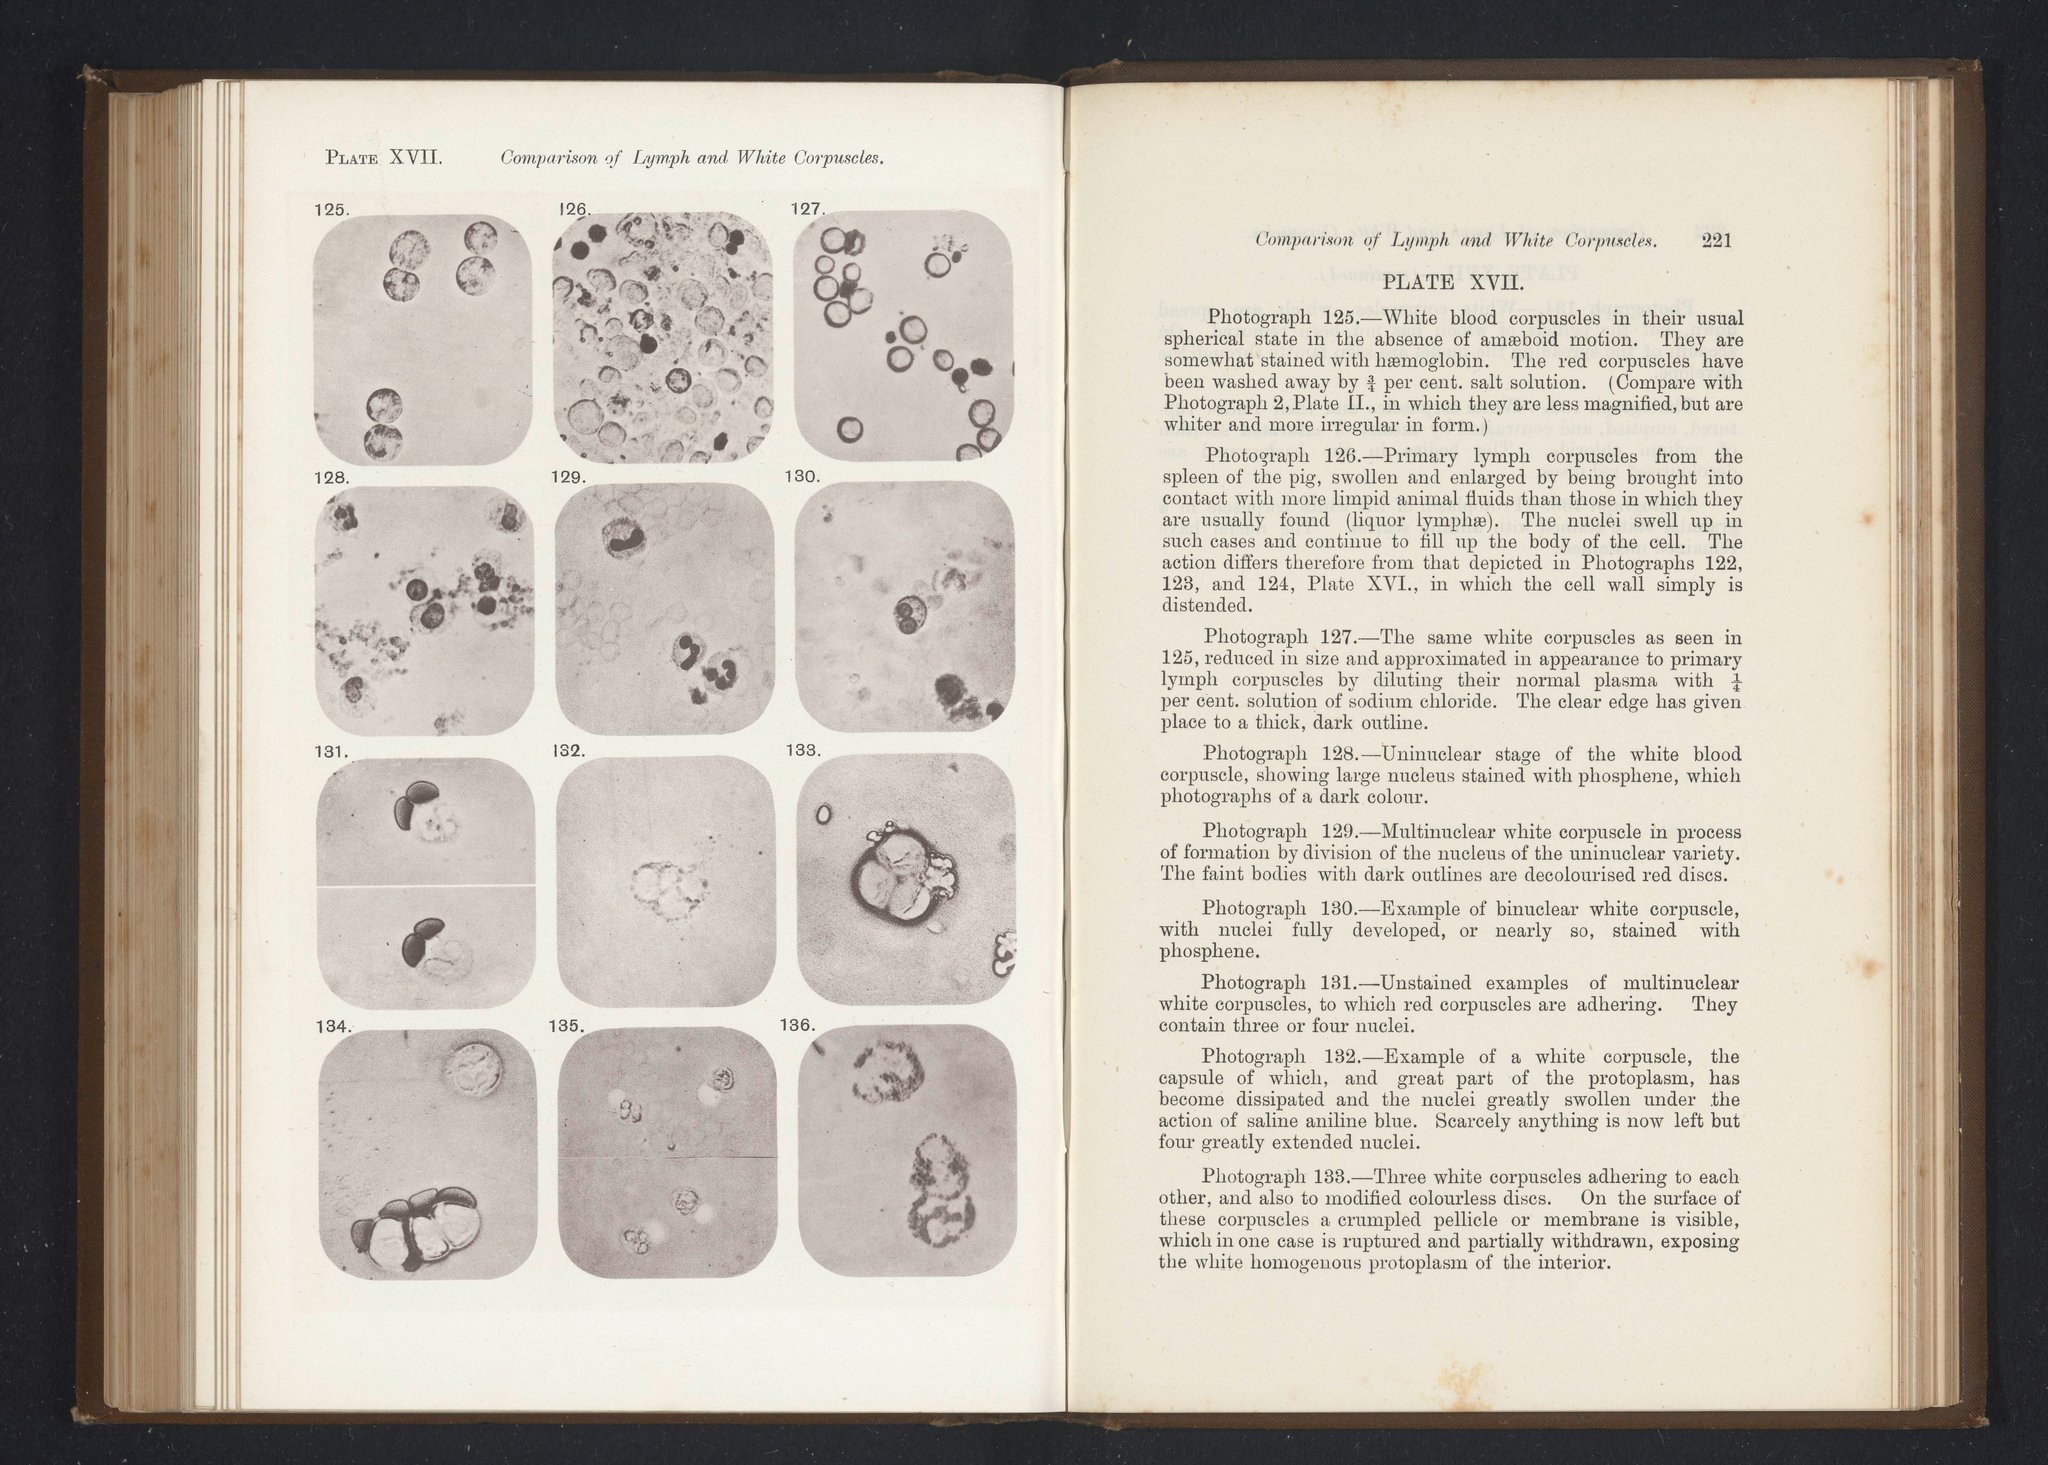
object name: page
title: Twaalf vergrotingen van witte bloedlichaampjes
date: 1872-1882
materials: paper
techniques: photograph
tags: blood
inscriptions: number: ‘Photo. 125. (...) Photo. 136.’, number: ‘Pl. XVII.’